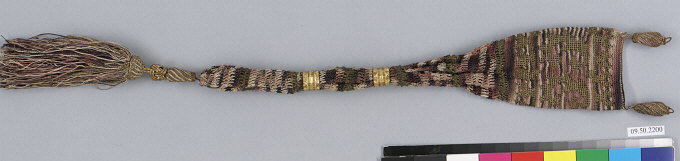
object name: purse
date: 1801-1900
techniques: crochet